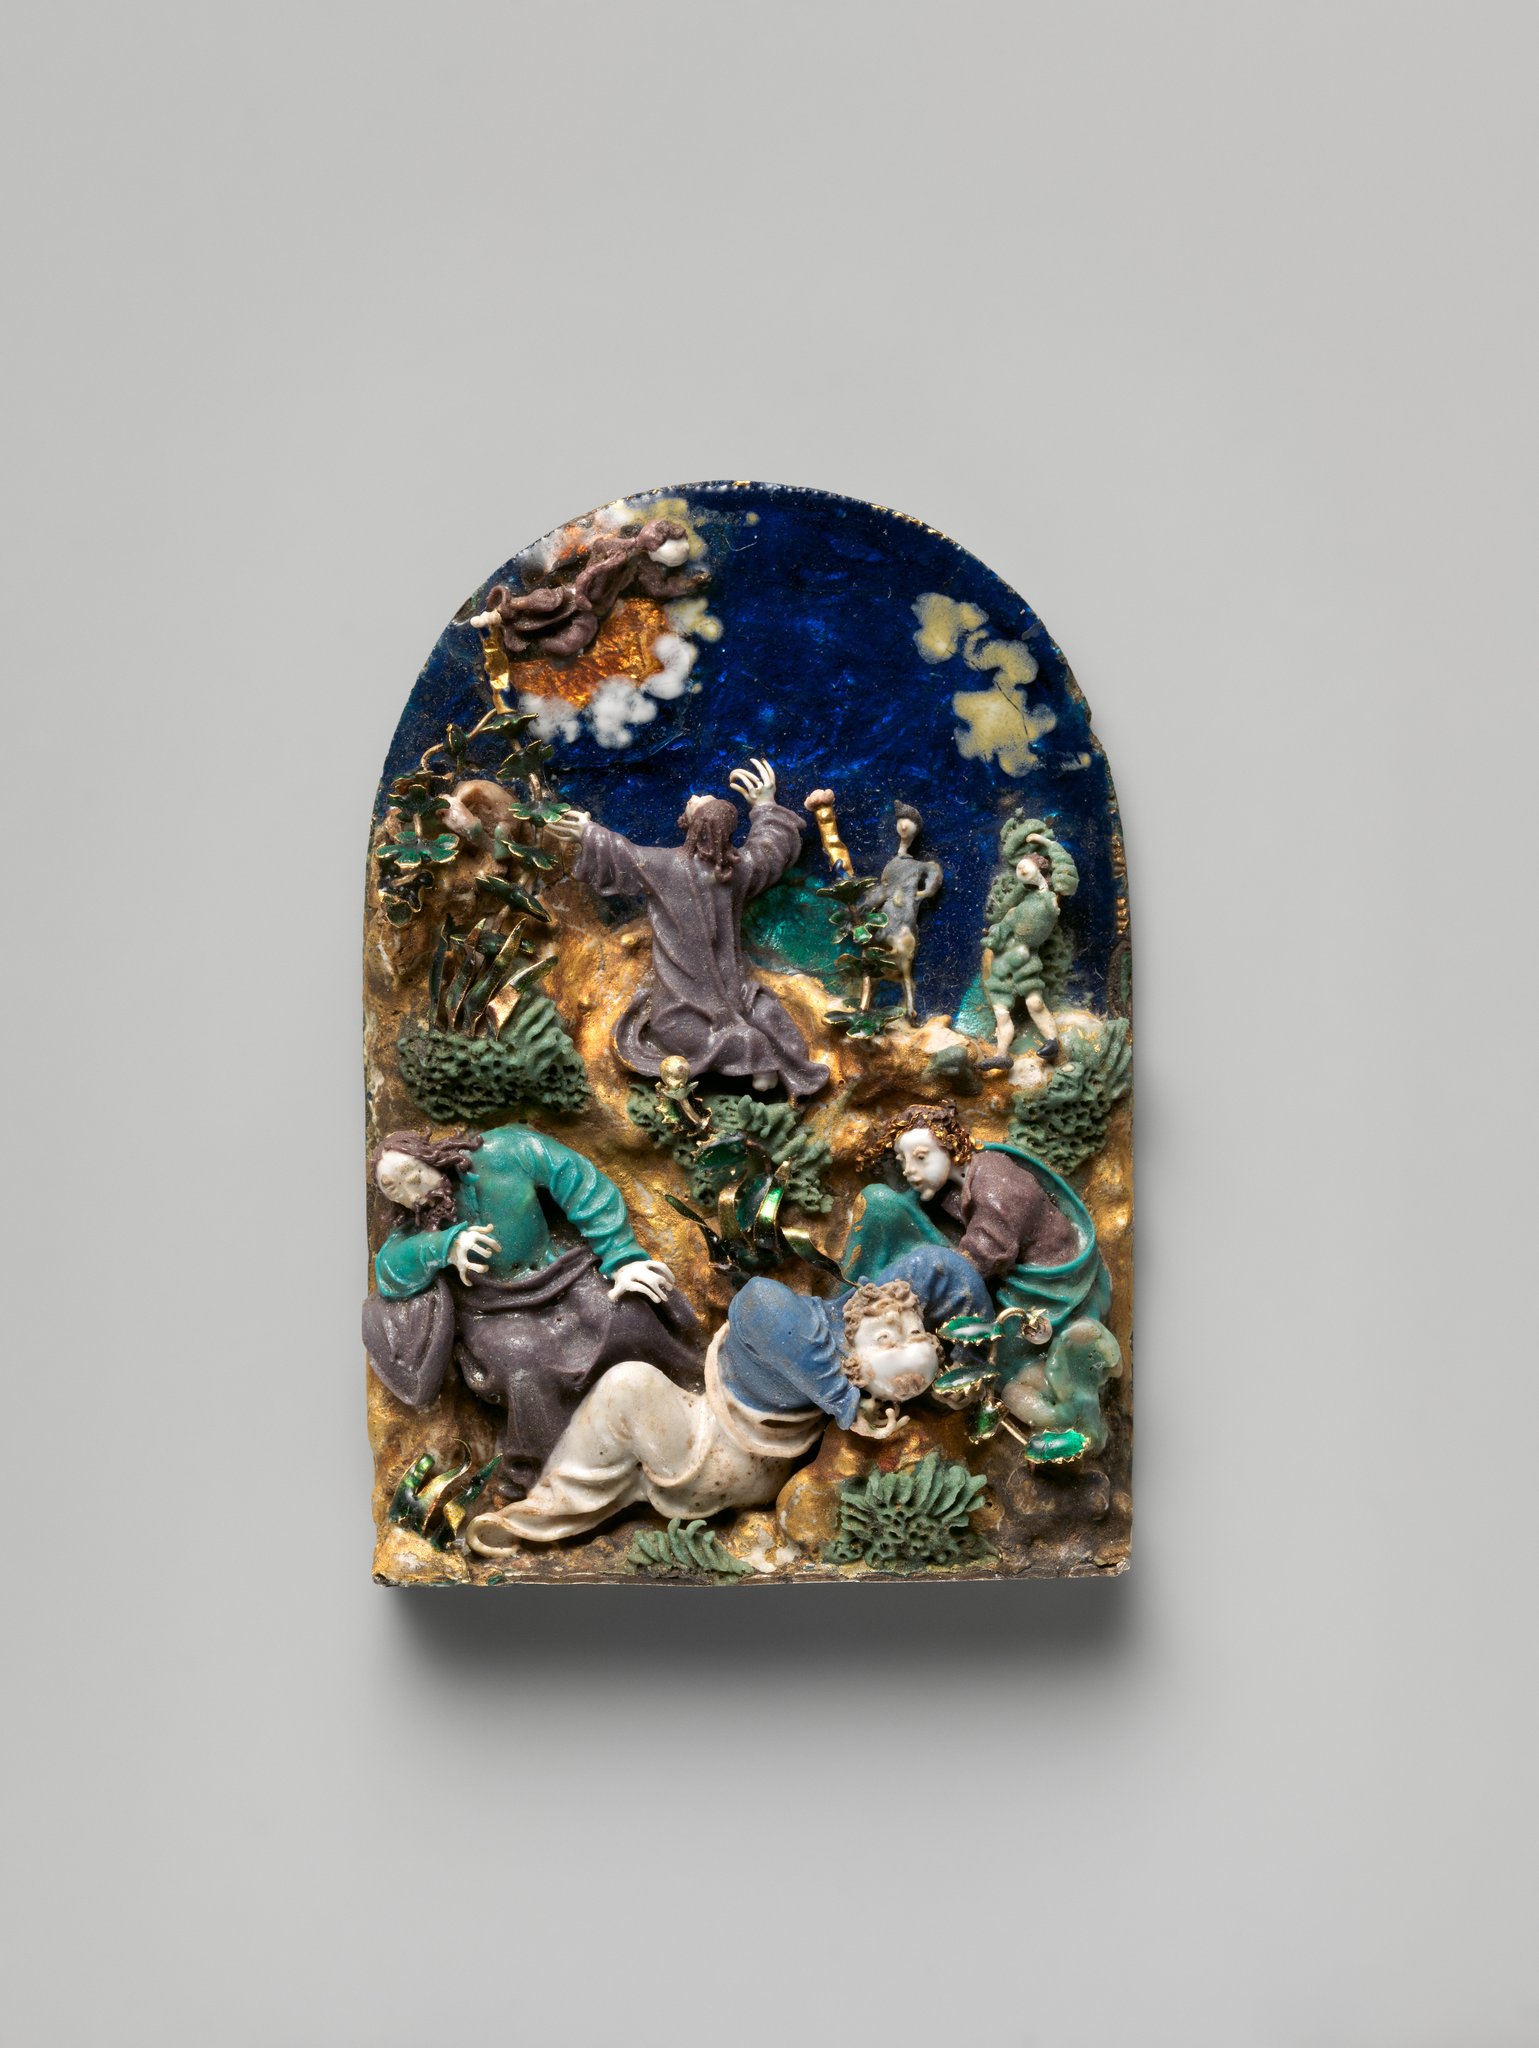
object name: plaquette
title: Christ in the Garden of Gethsemane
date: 1520-1530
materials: enamel, glass, gold, silver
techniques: lampwork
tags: gardens,men,christ